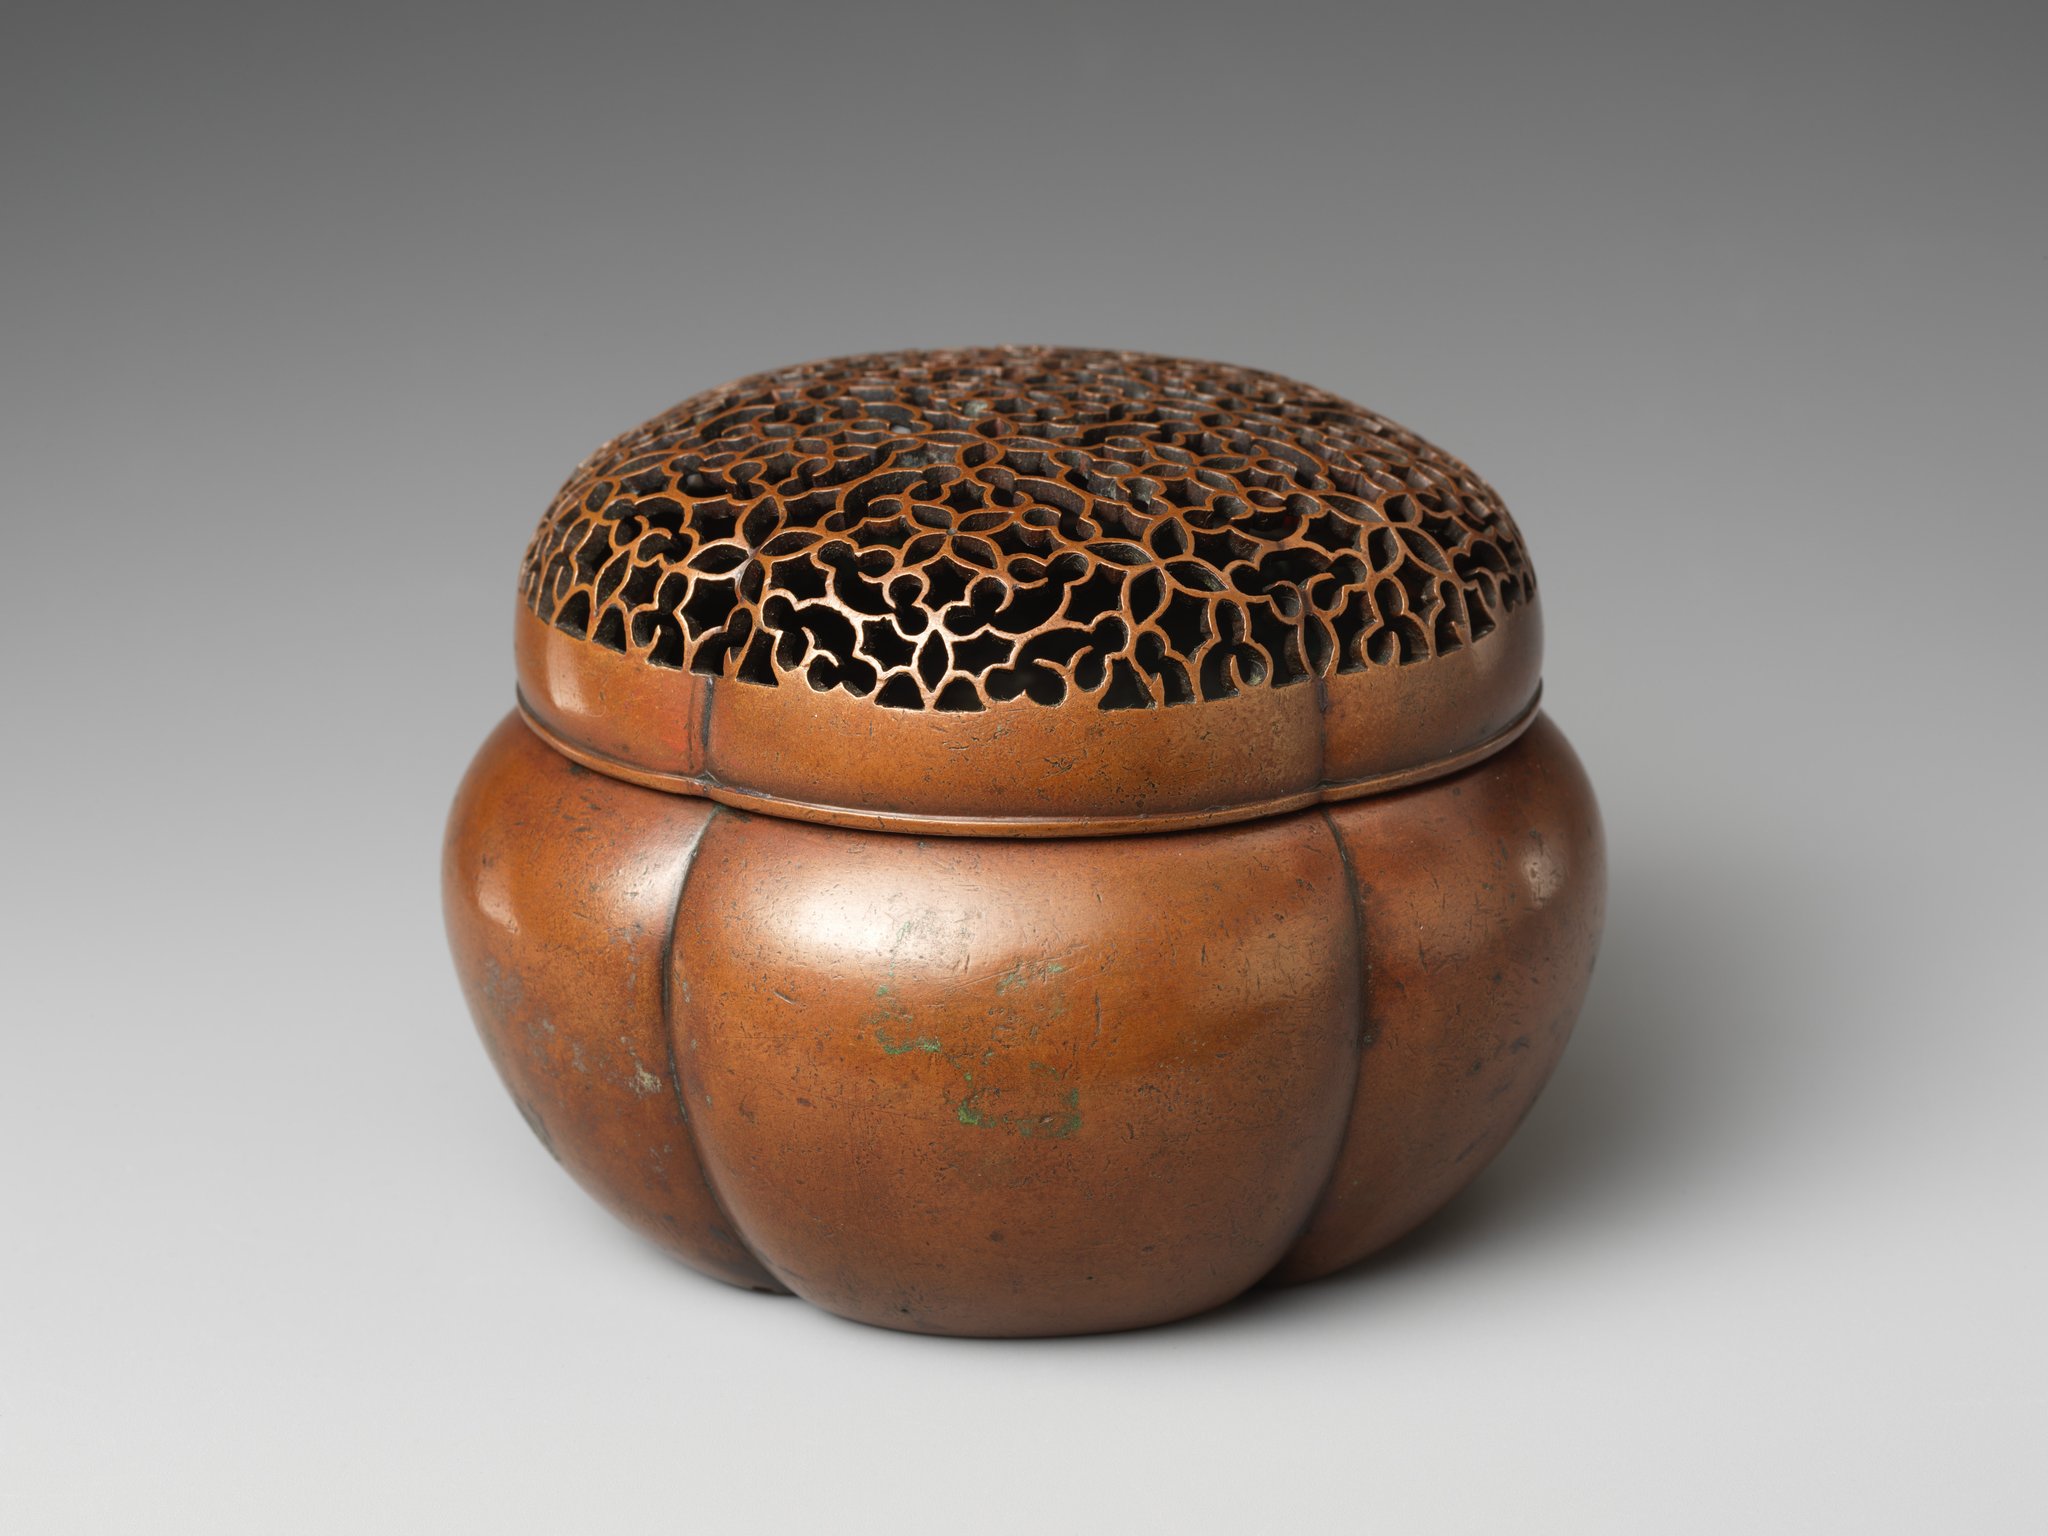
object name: hand warmer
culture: chinese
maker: zhang mingqi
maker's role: artist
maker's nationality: chinese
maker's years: 1600-1644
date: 1601-1700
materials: copper alloy